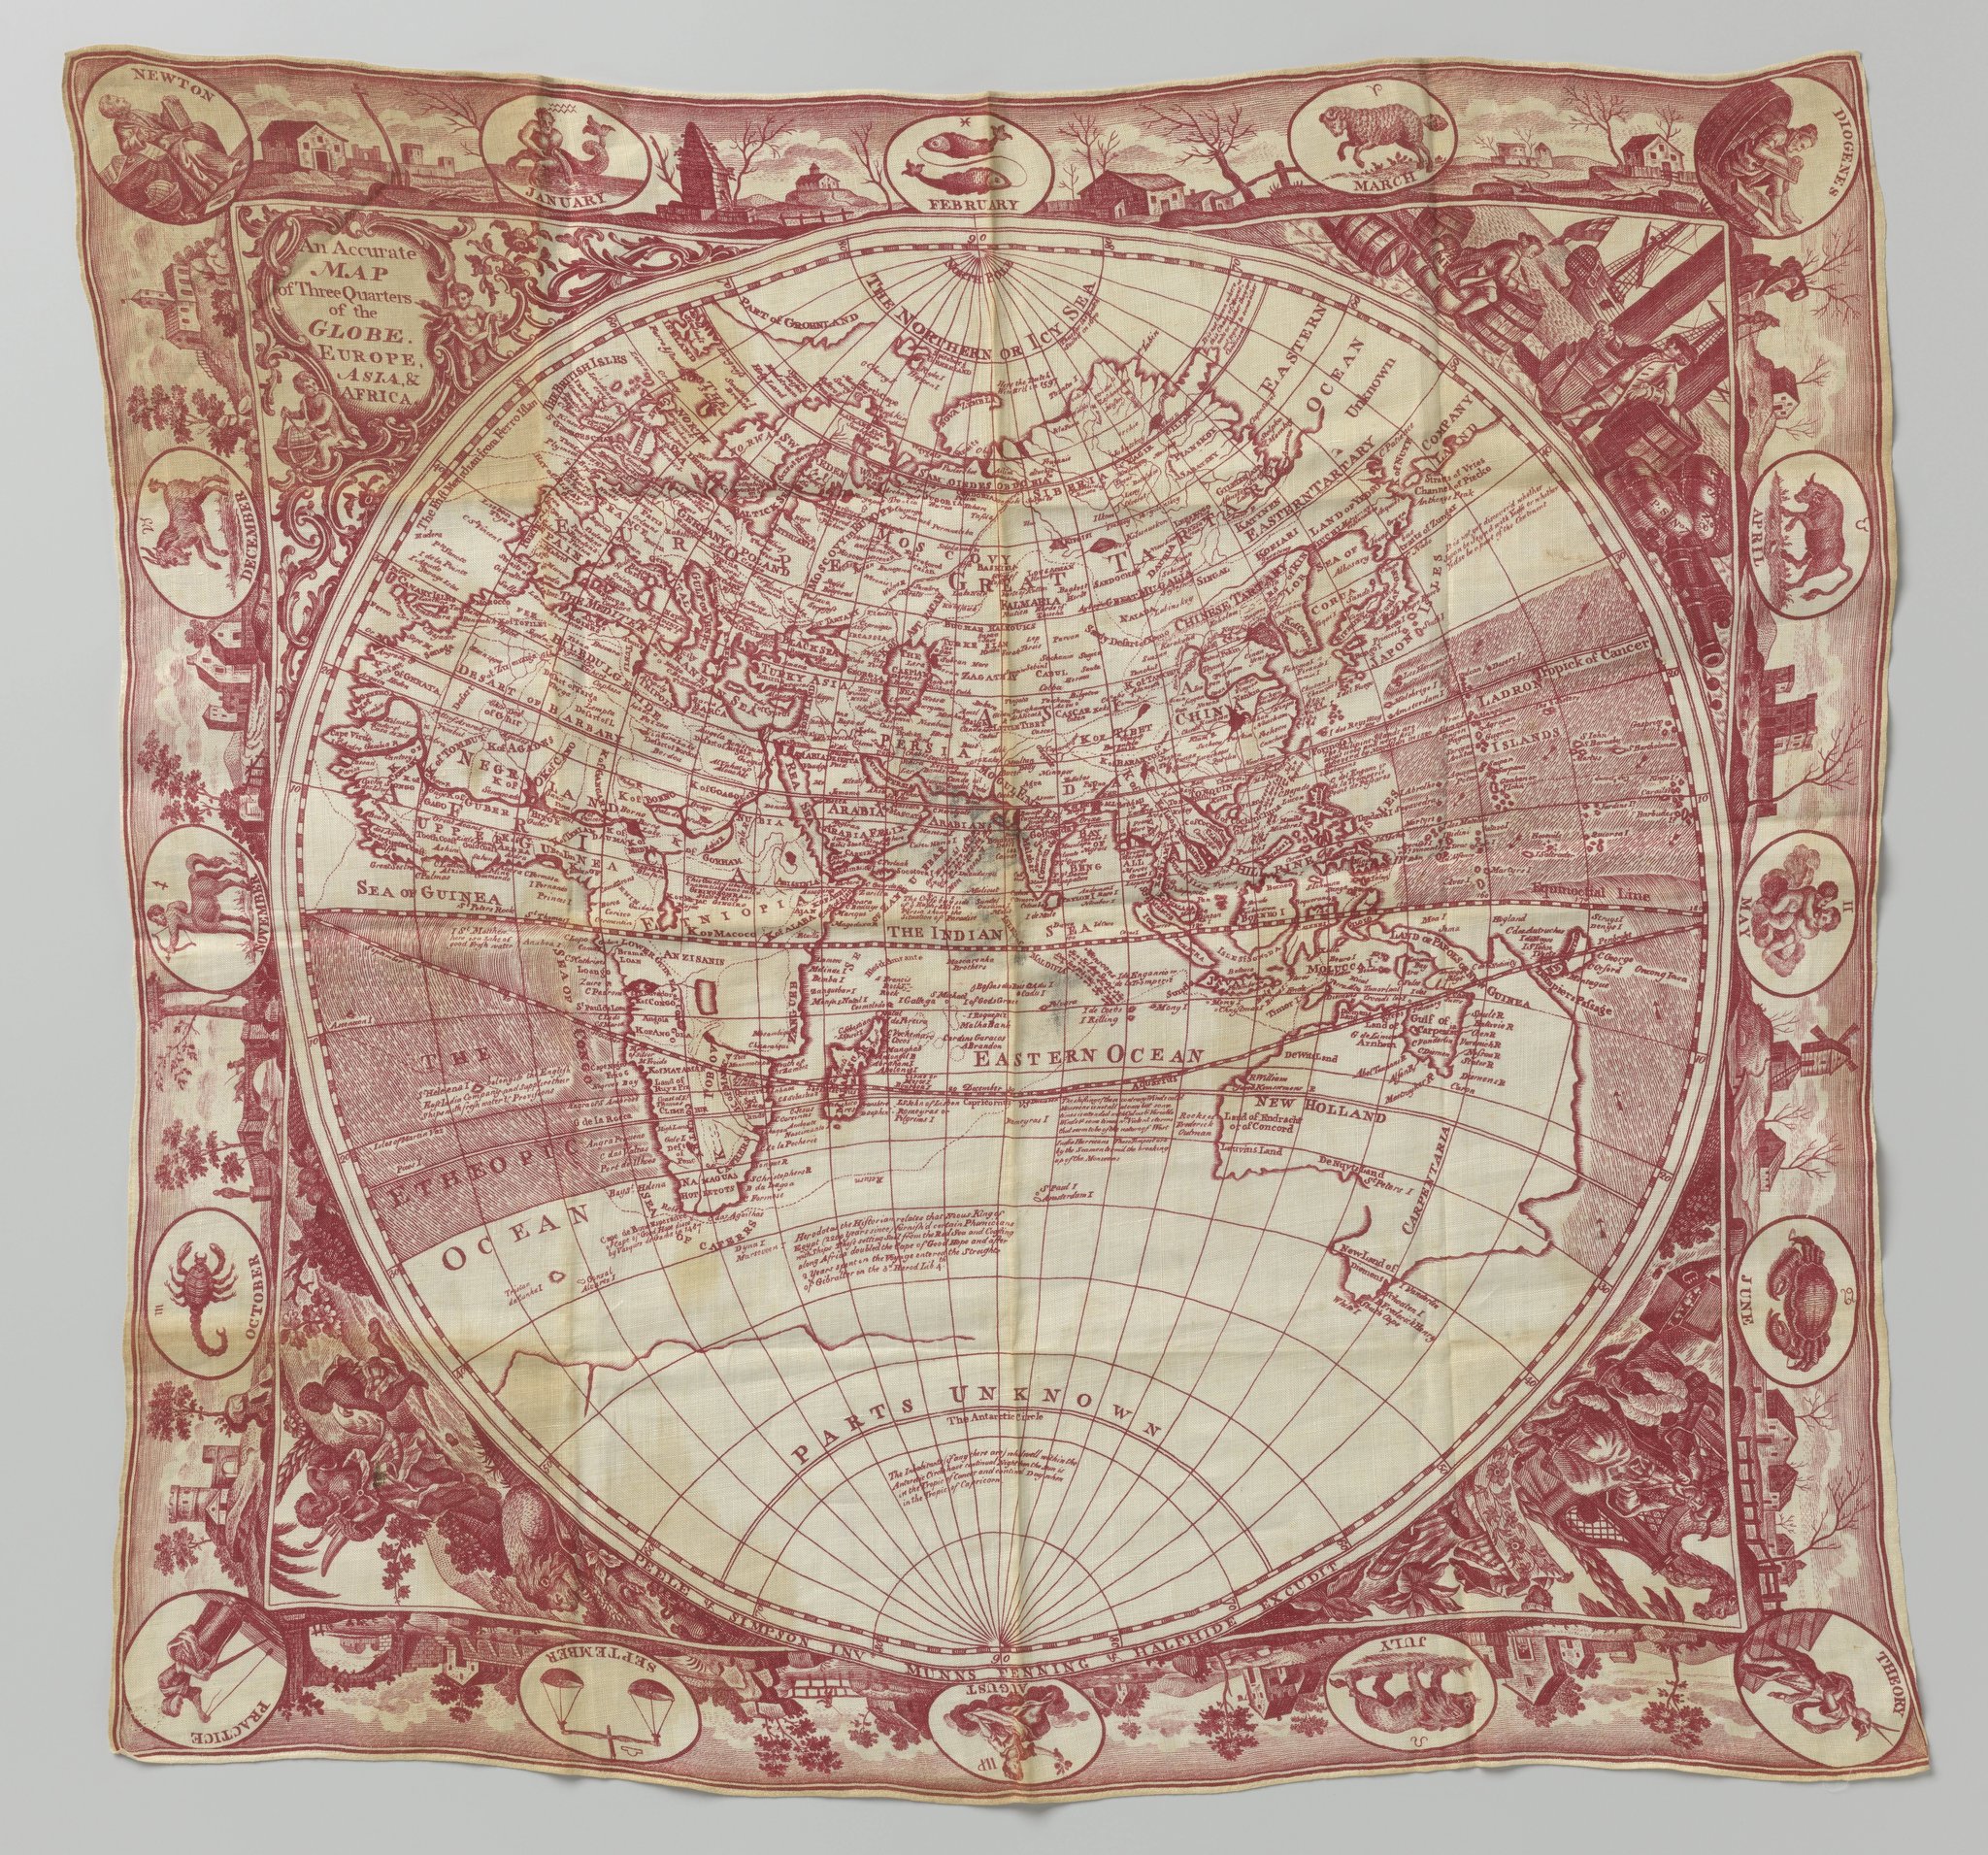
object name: towel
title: Doek van linnen, bedrukt met de wereldkaart en de tekens van de dierenriem.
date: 1790-1800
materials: linen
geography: england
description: Doek van linnen, bedrukt met de wereldkaart en de tekens van de dierenriem.